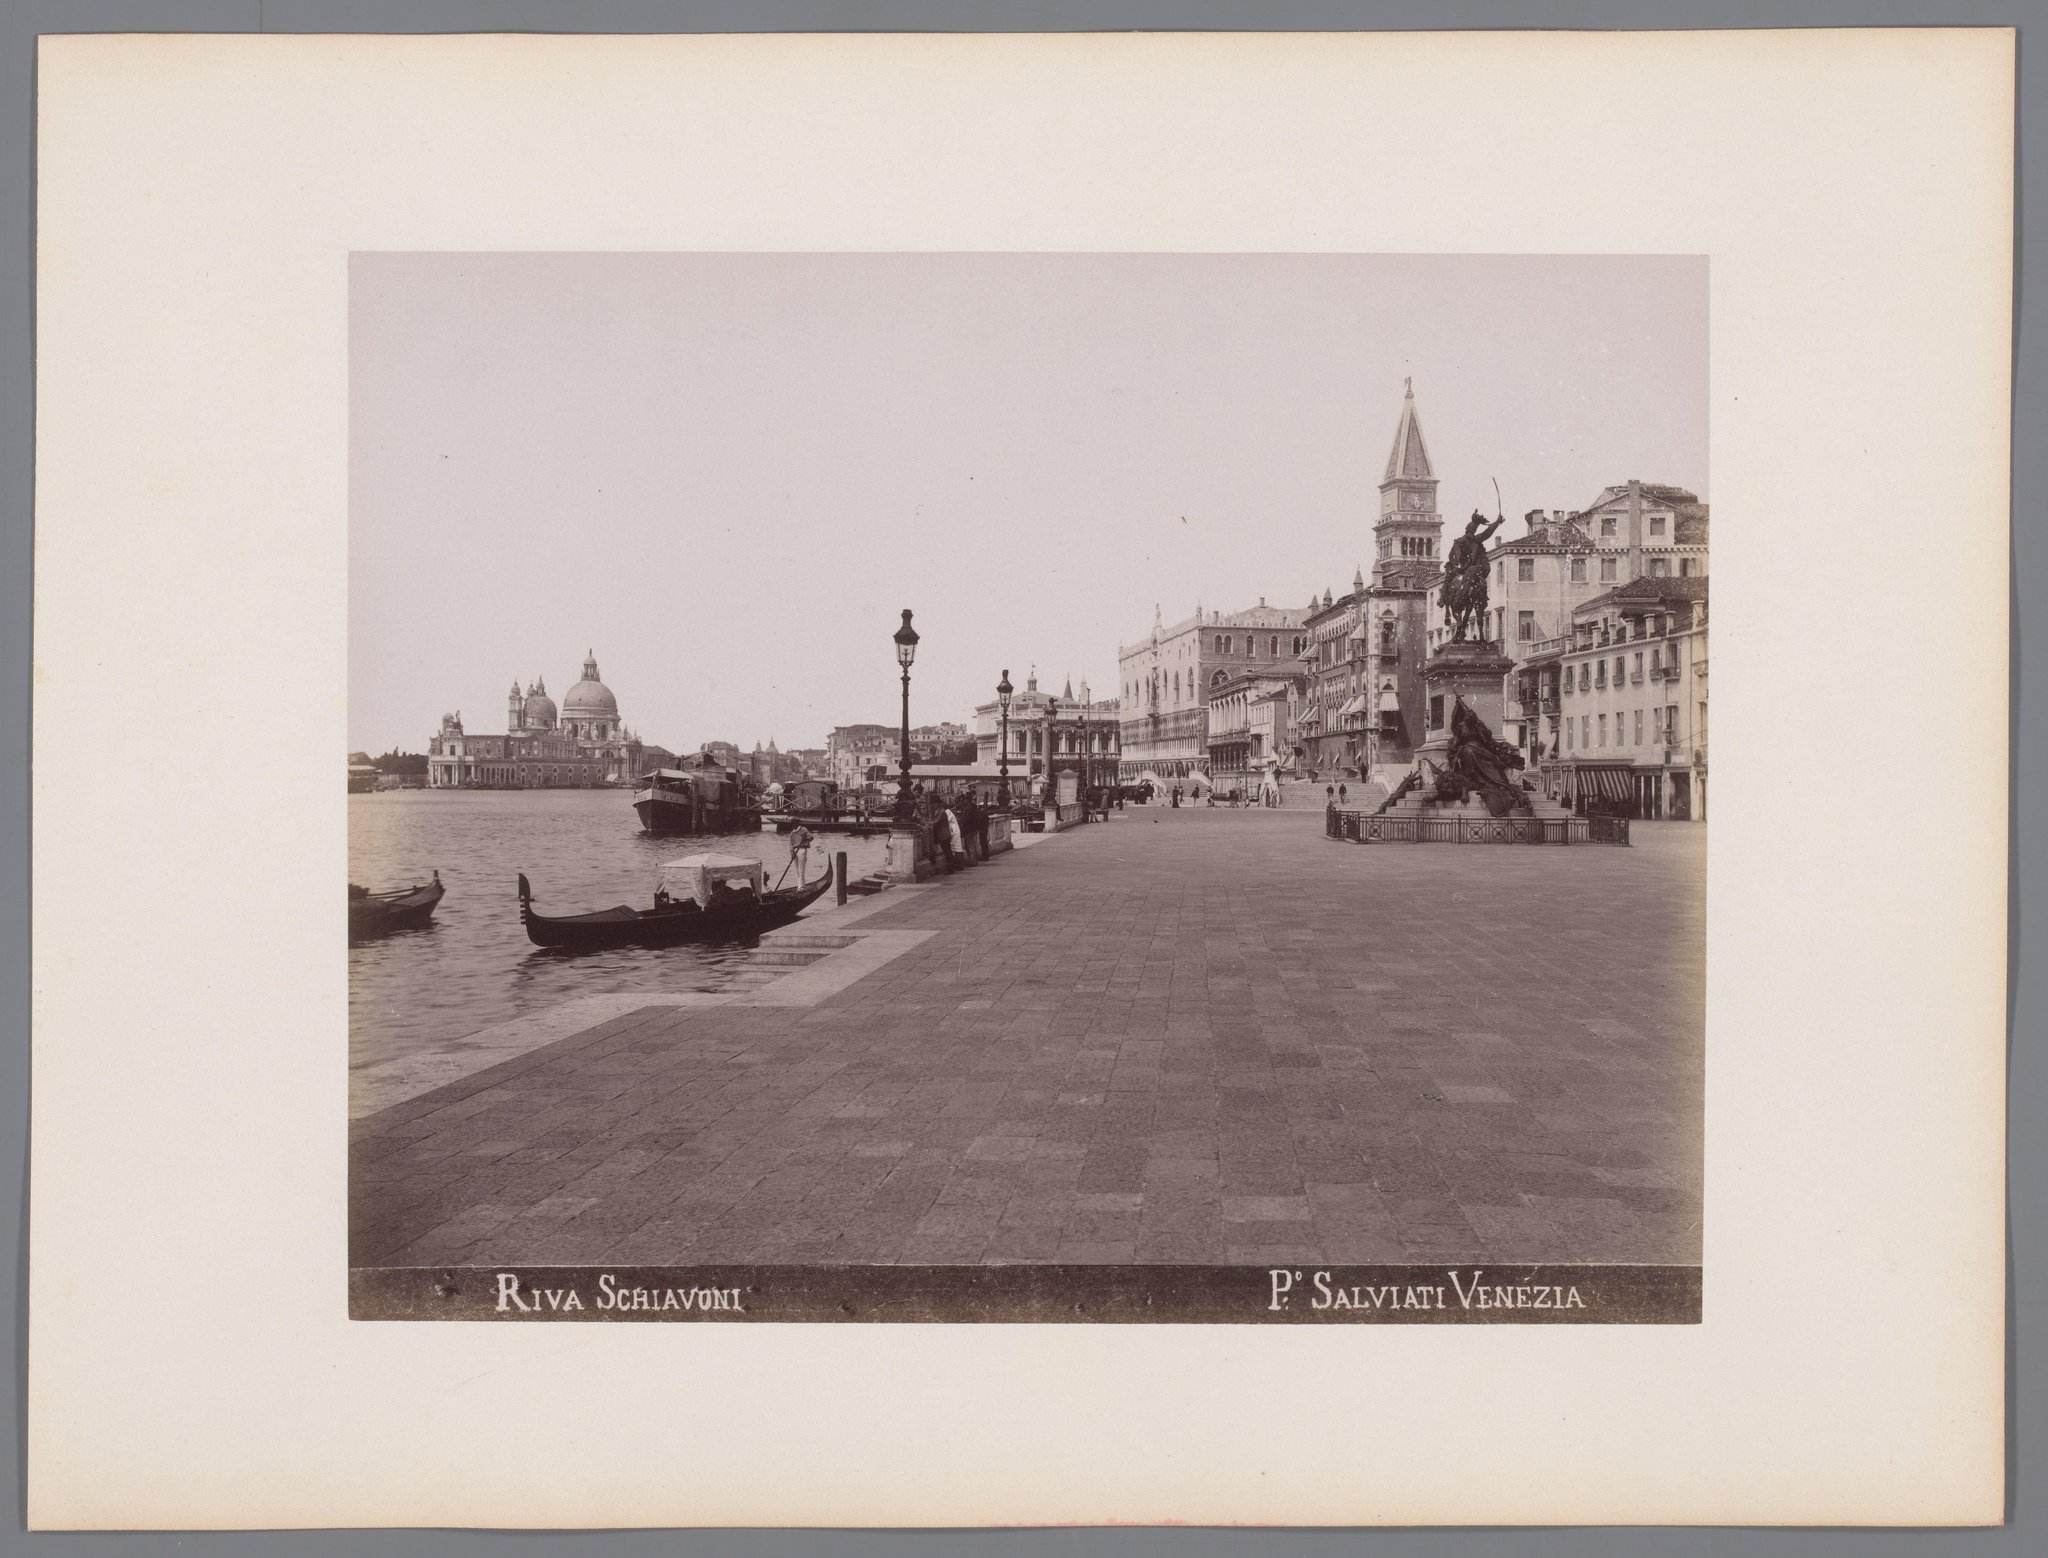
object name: photograph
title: Riva Schiavoni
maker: paolo salviati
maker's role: fotograaf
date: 1860-1870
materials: cardboard, paper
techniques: albumen print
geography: venice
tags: canals, waters (in city), quay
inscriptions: inscription: ‘Venetie’